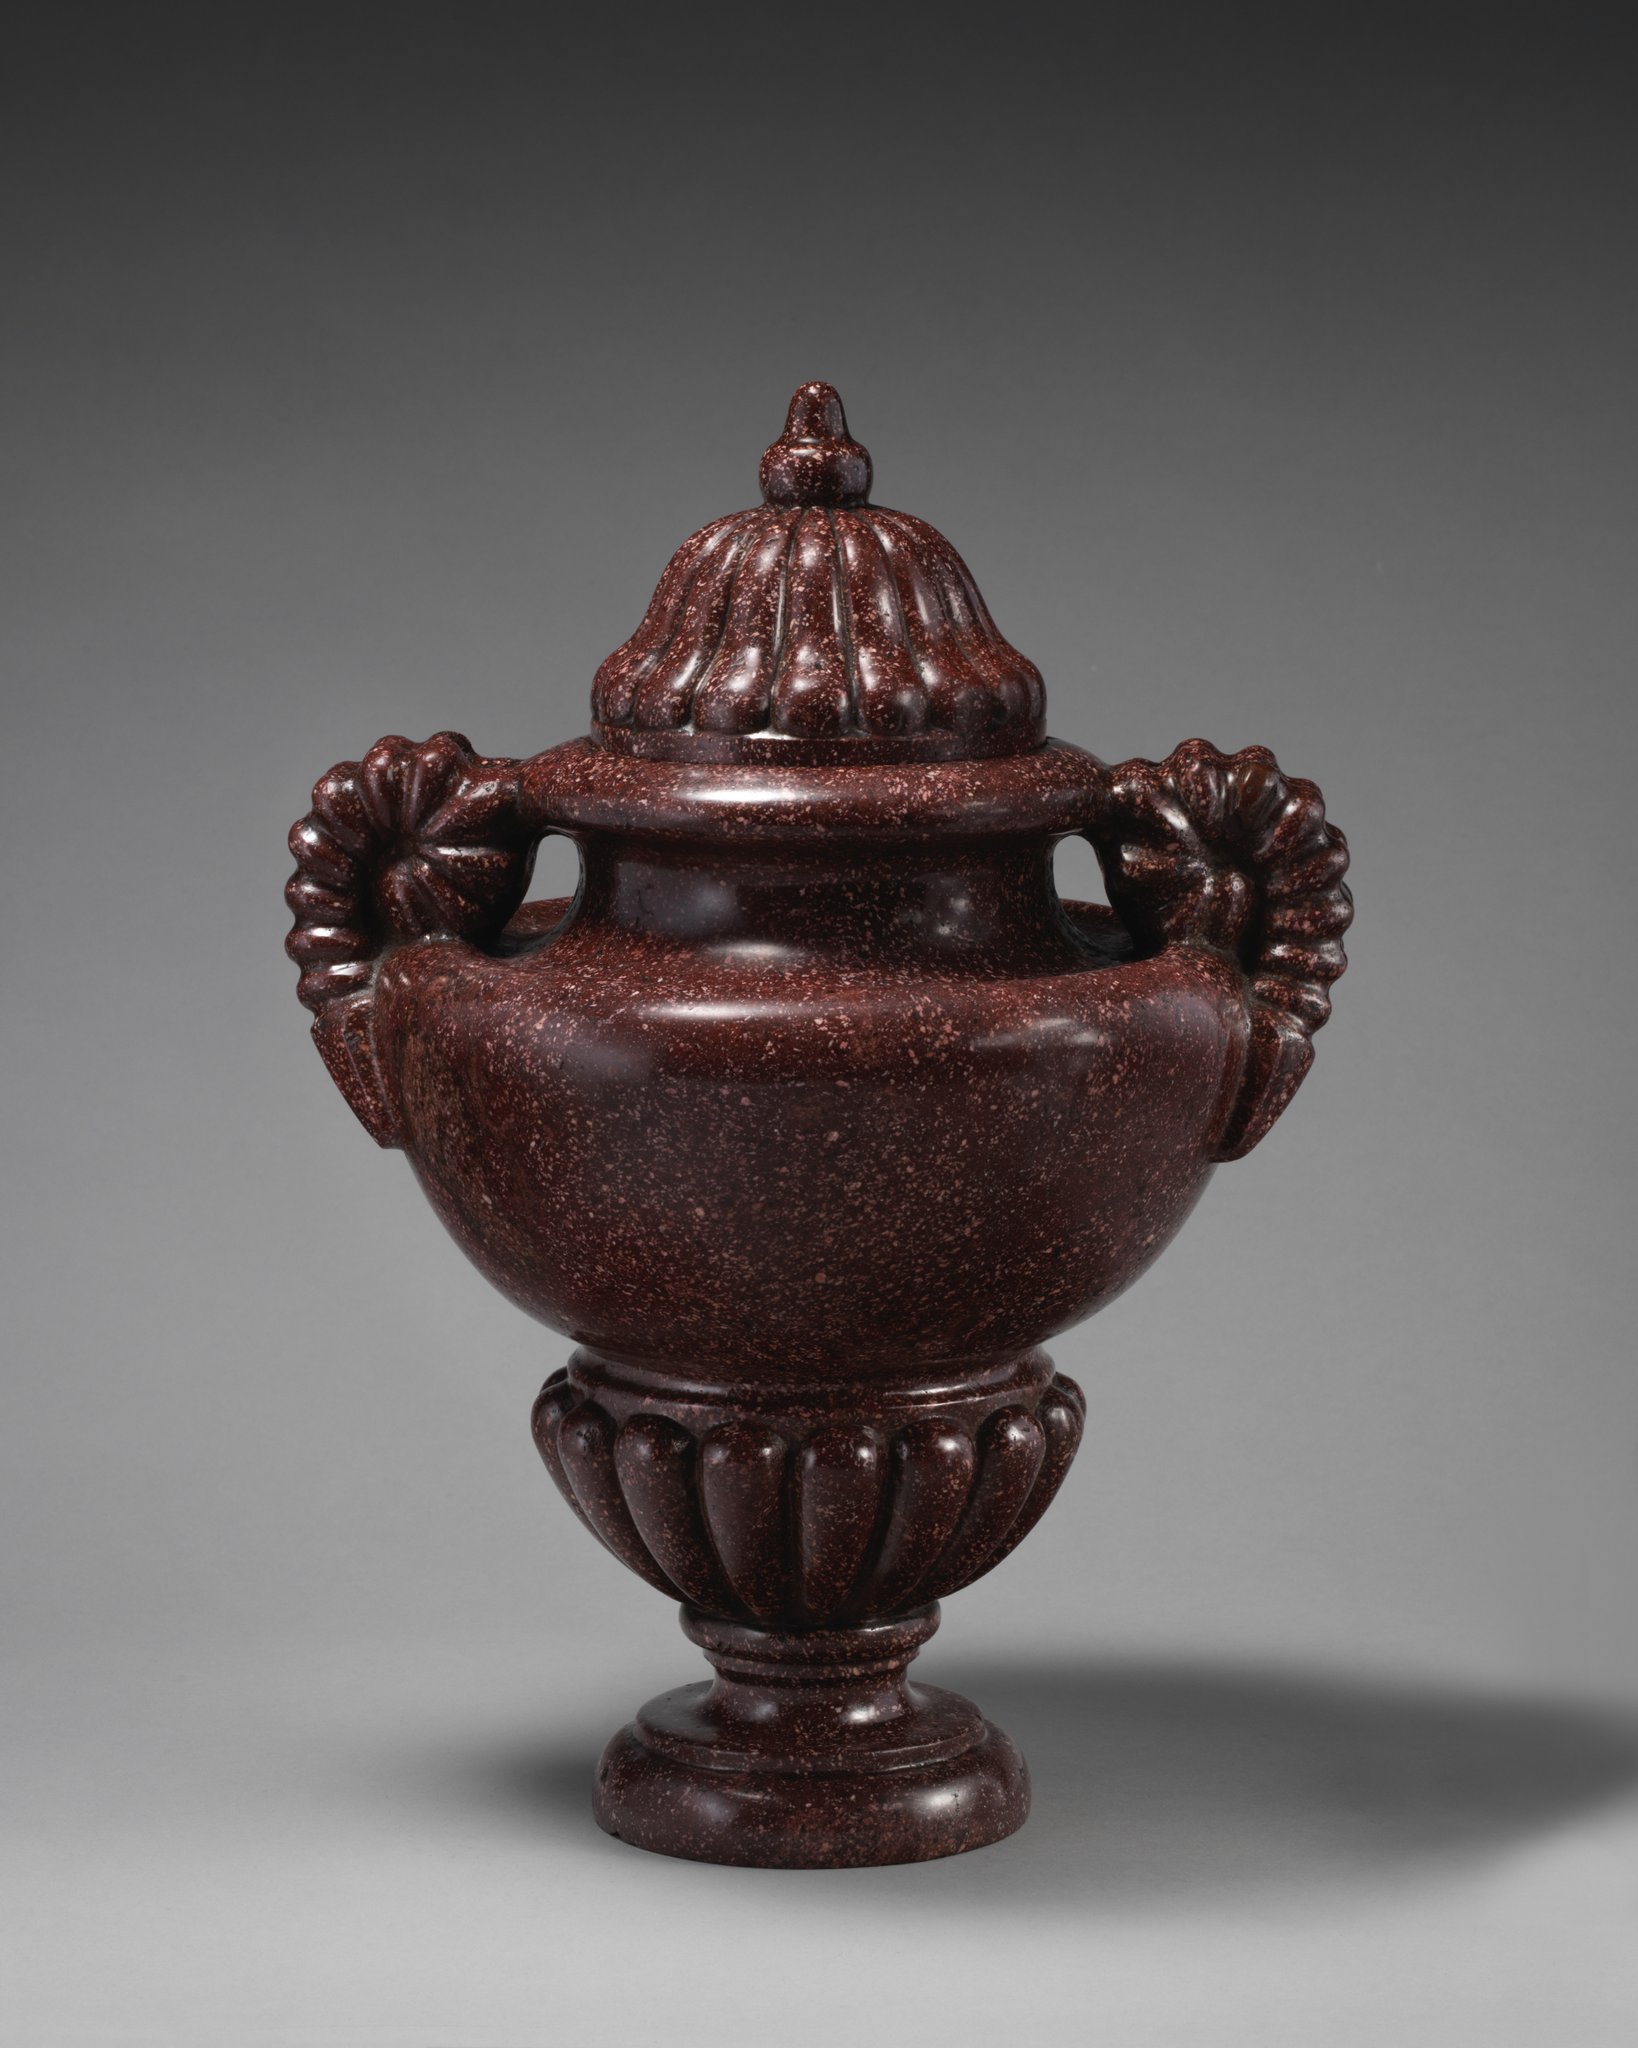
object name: urn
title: Urn with ram's horn handles and gadrooned lid and socle (one of a pair)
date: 1601-1650